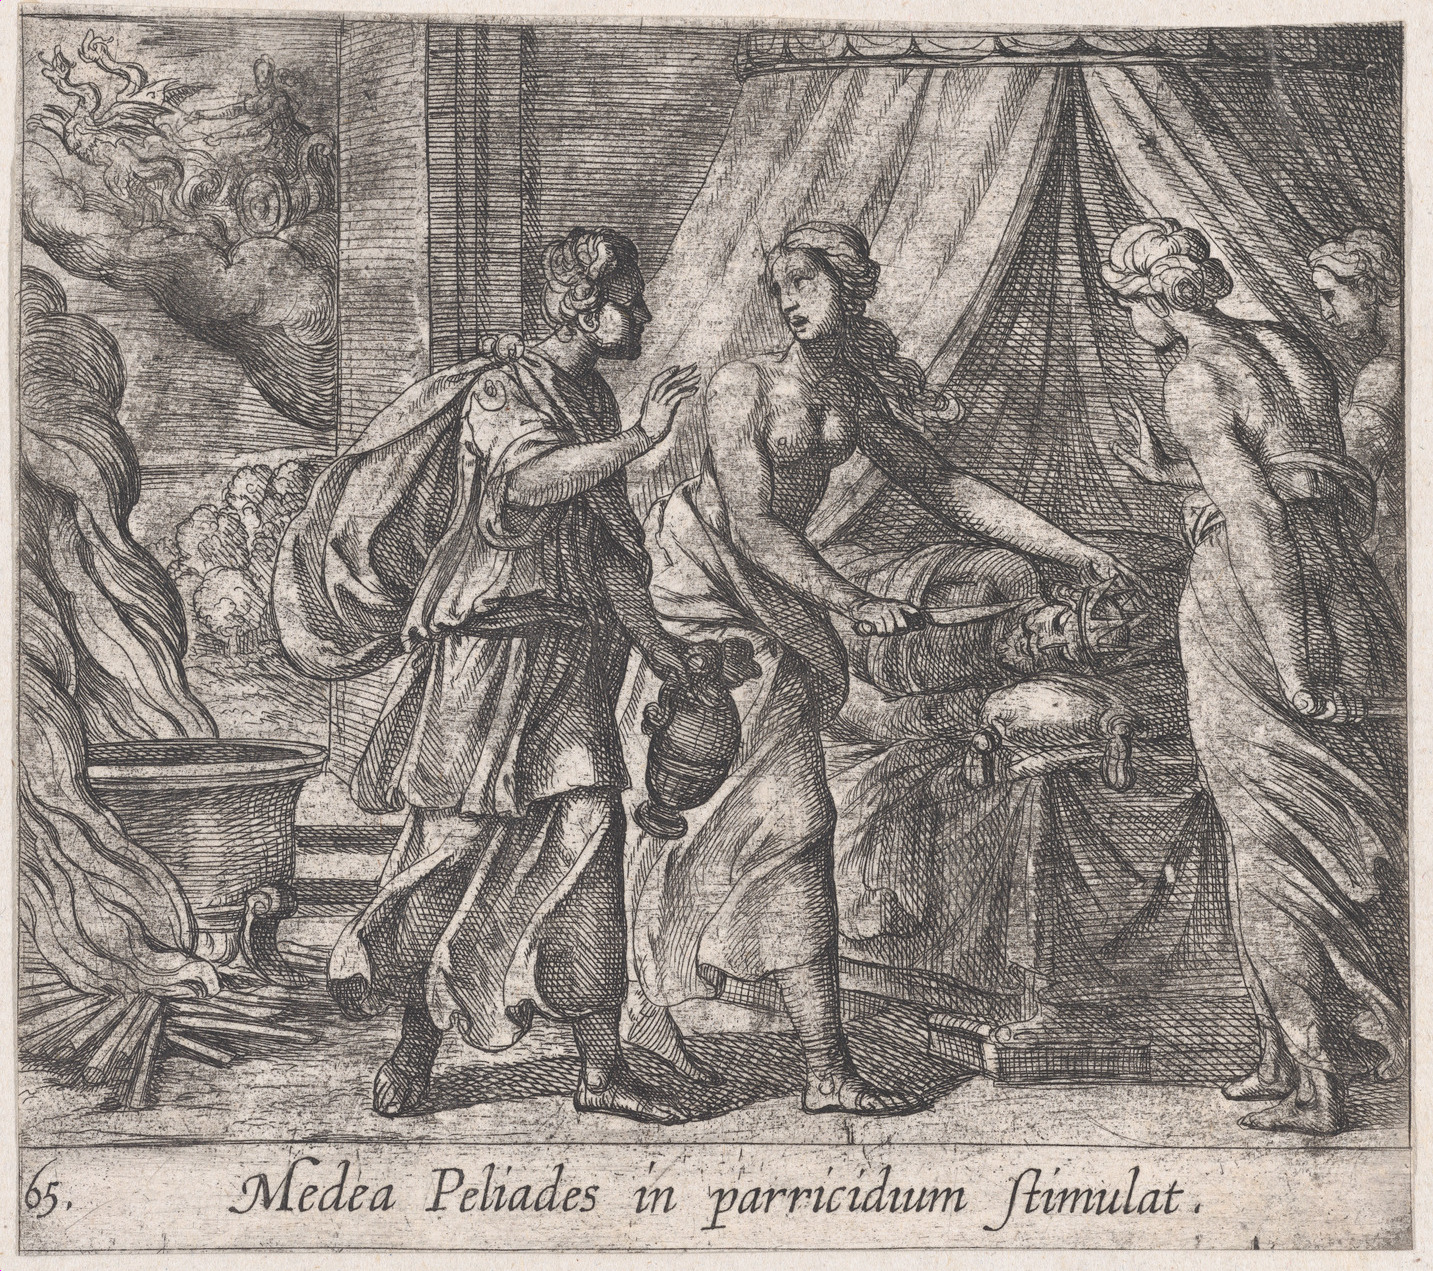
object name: print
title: Plate 65: Medea Urging the Daughters of King Pellias to Murder Their Father (Medea Peliades in parricidium stimulat), from Ovid's 'Metamorphoses'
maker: antonio tempesta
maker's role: artist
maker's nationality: italian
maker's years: 1555-1630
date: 1606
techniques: etching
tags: kings,women,medea